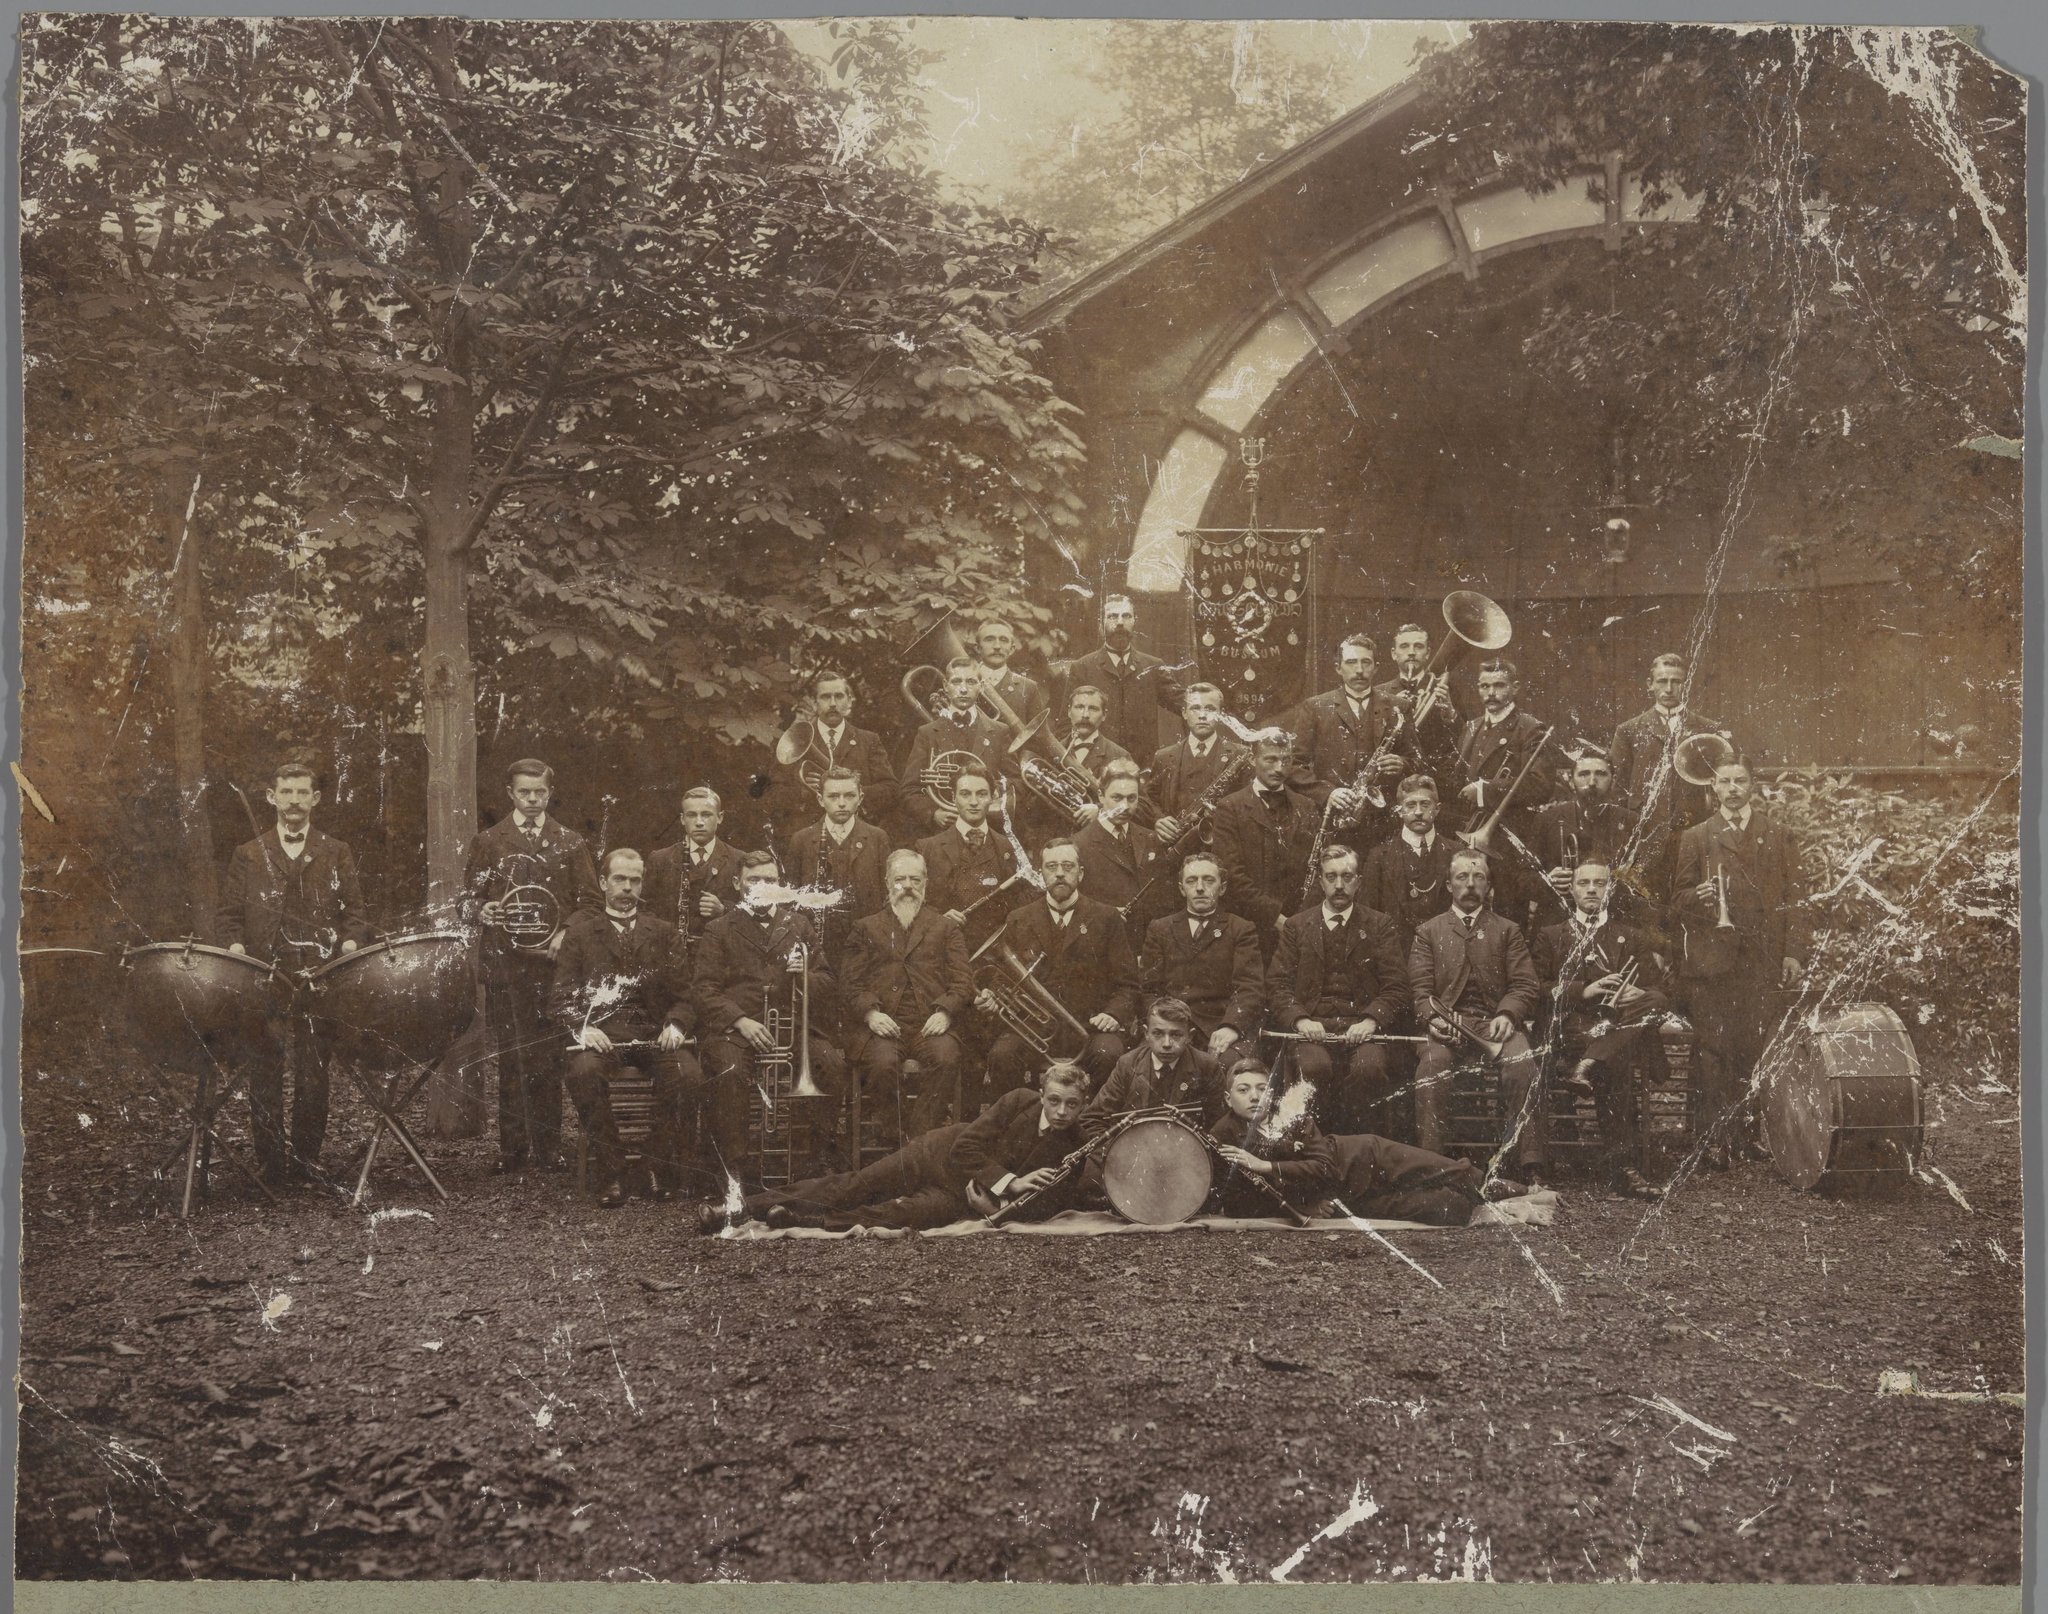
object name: photograph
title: Groepsportret van harmonie 'Crescendo'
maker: Anonymous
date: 1900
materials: cardboard, photographic support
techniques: collodion silver print